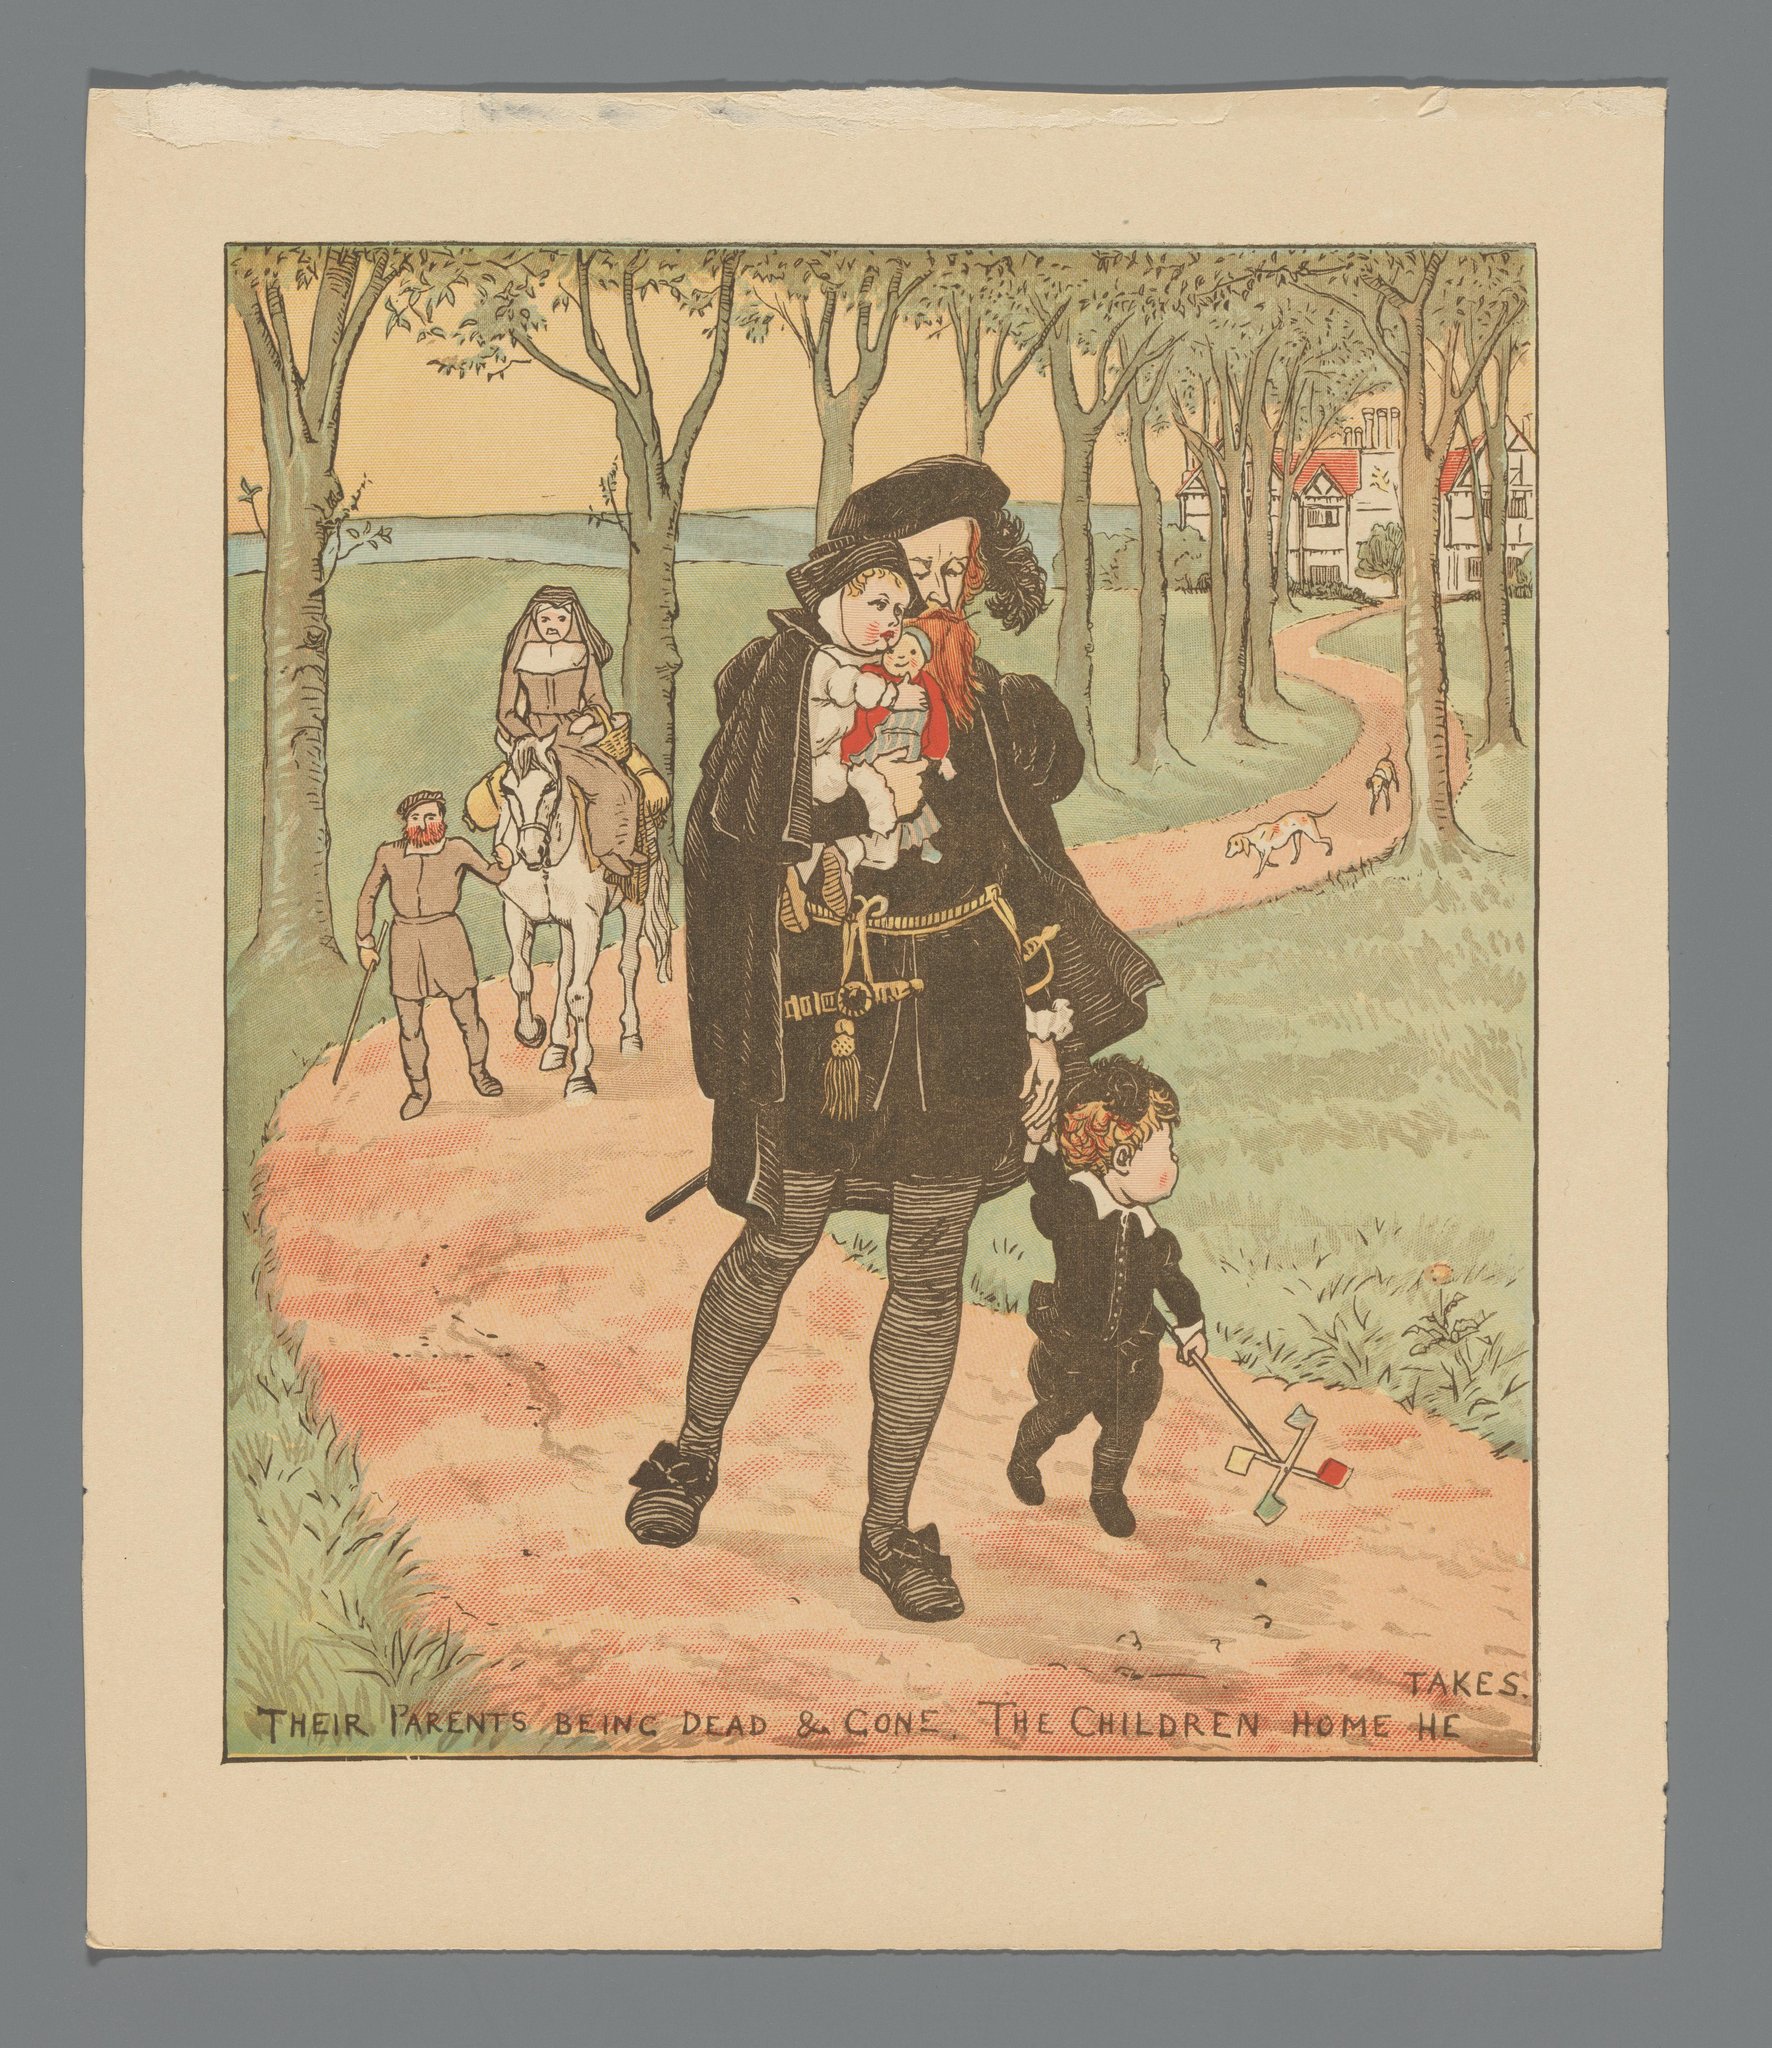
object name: book illustration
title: Landschap met familie op een landweg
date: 1879-1927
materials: paper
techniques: wood engraving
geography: london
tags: riding a horse, ass, or mule; rider, horseman, carrying a child on the hip, astride, road, path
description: Prent uit: The babes in the wood. Londen: George Routledge & Sons, 1879. Of uit een later gepubliceerde (gebundelde) uitgave.